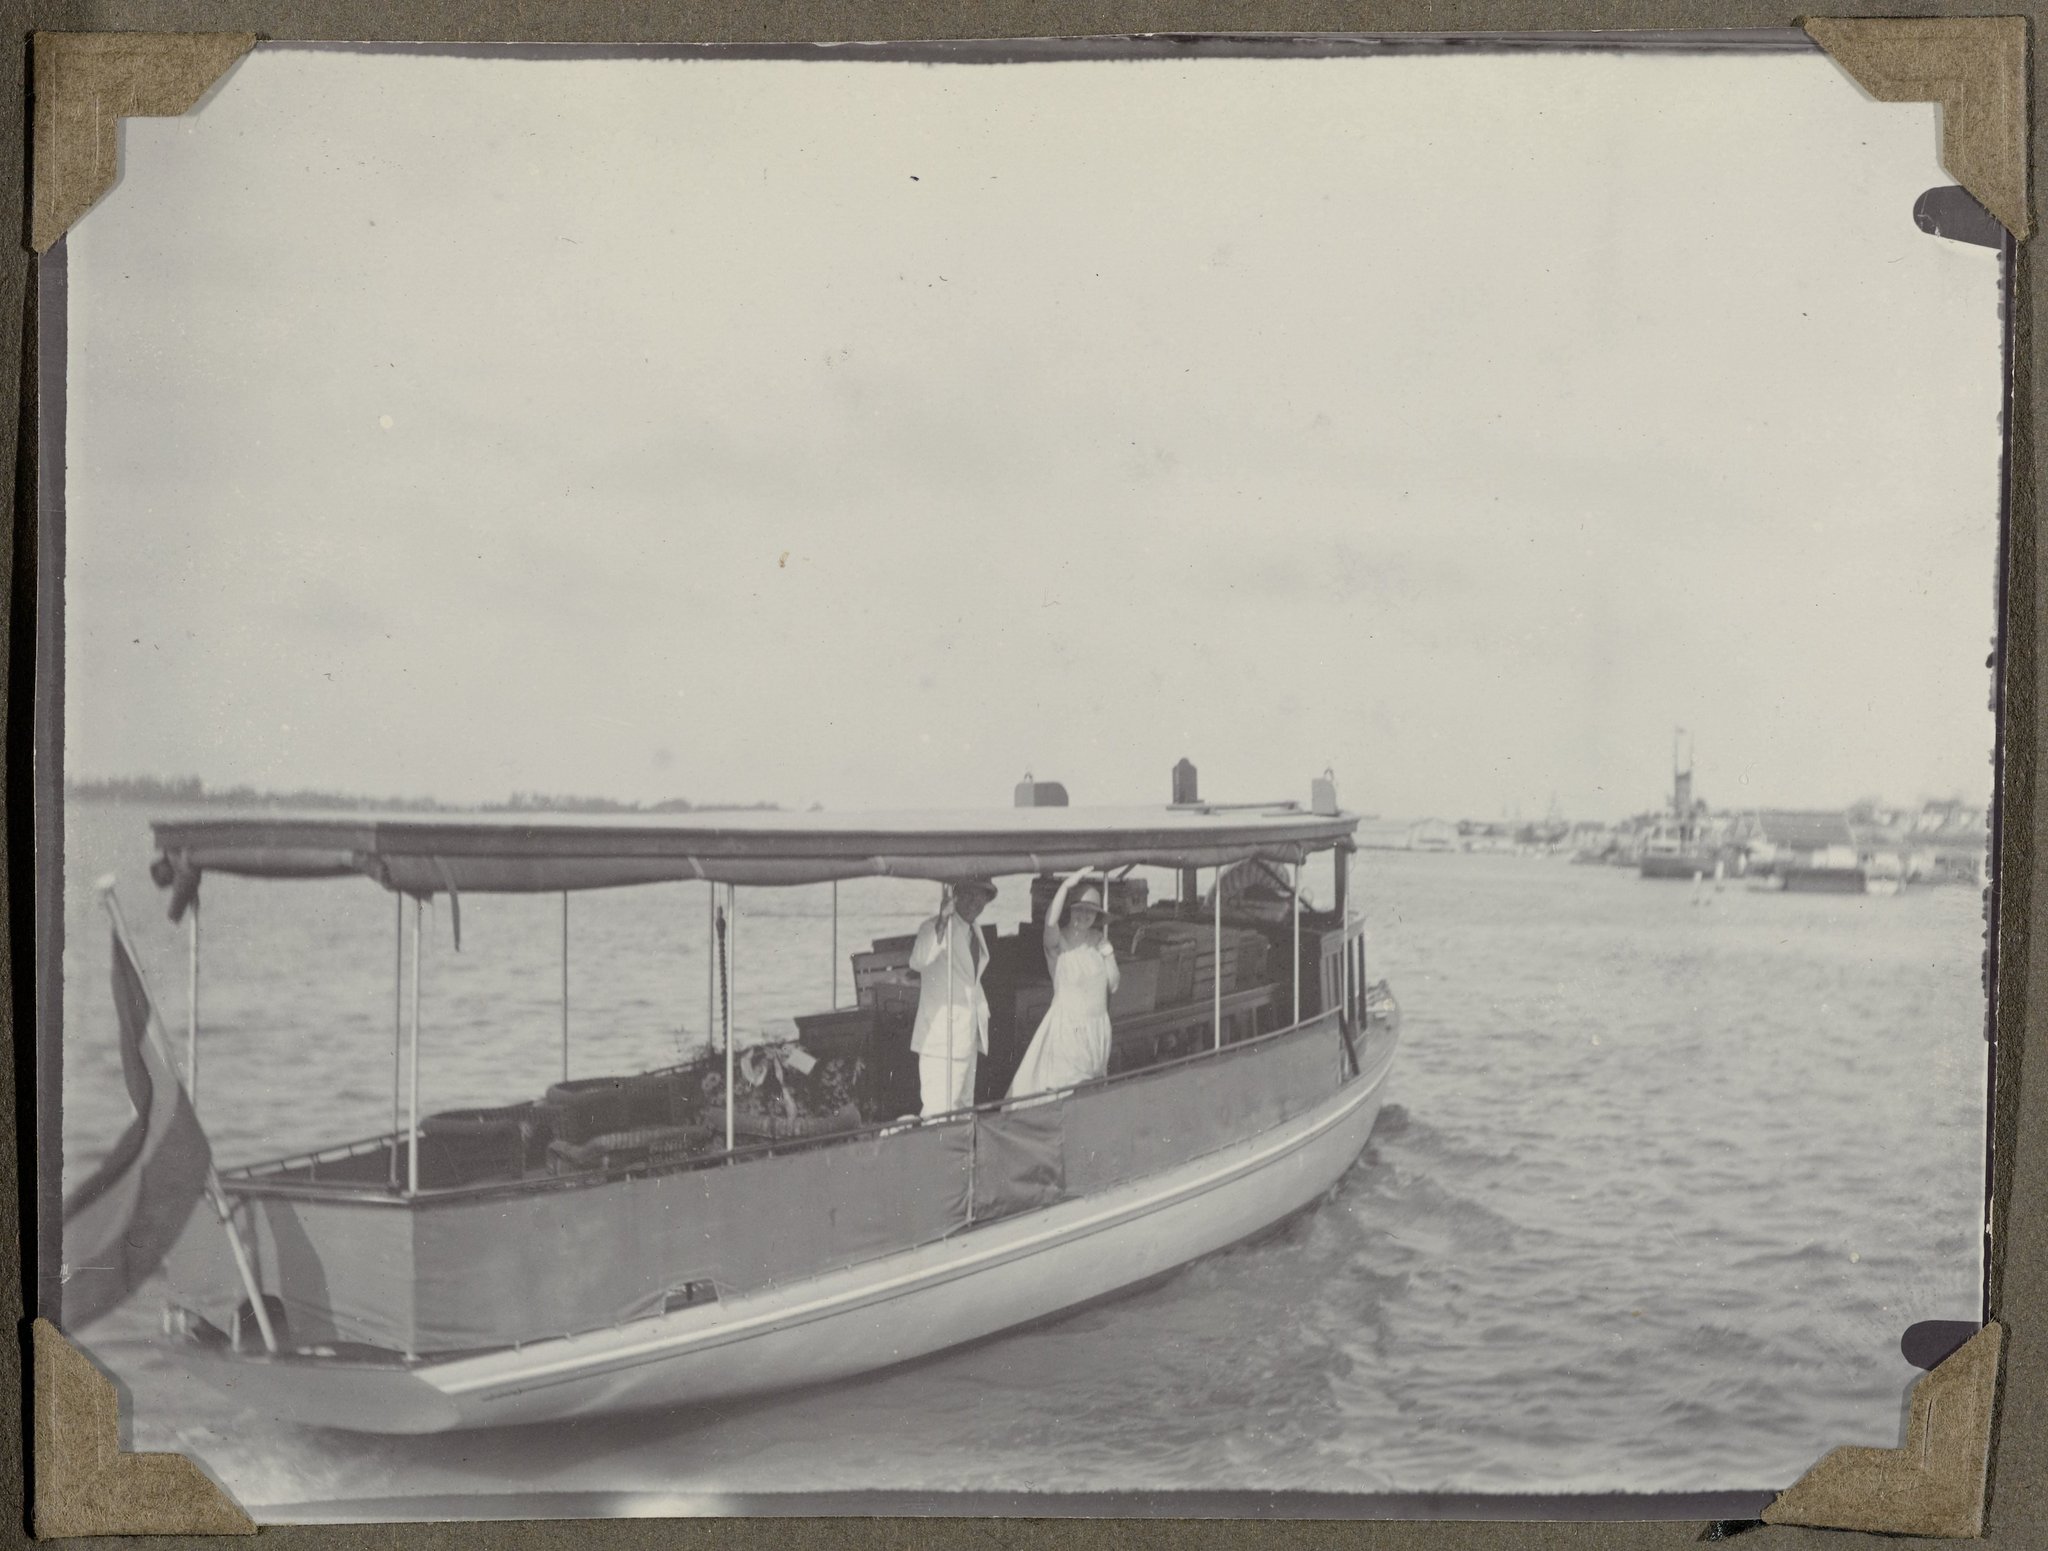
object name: photograph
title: Echtpaar Jetten op een rivierboot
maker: Anonymous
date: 1925-1927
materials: photographic support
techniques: photography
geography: suriname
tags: river, suriname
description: Het echtpaar Jetten op een rivierboot, bij Paramaribo (?). Foto met hoekjes bevestigd op een bladzijde van een albumblad in het fotoalbum over de familie Jetten en het leven en werken in de mijnstad Moengo in Suriname rond 1927.